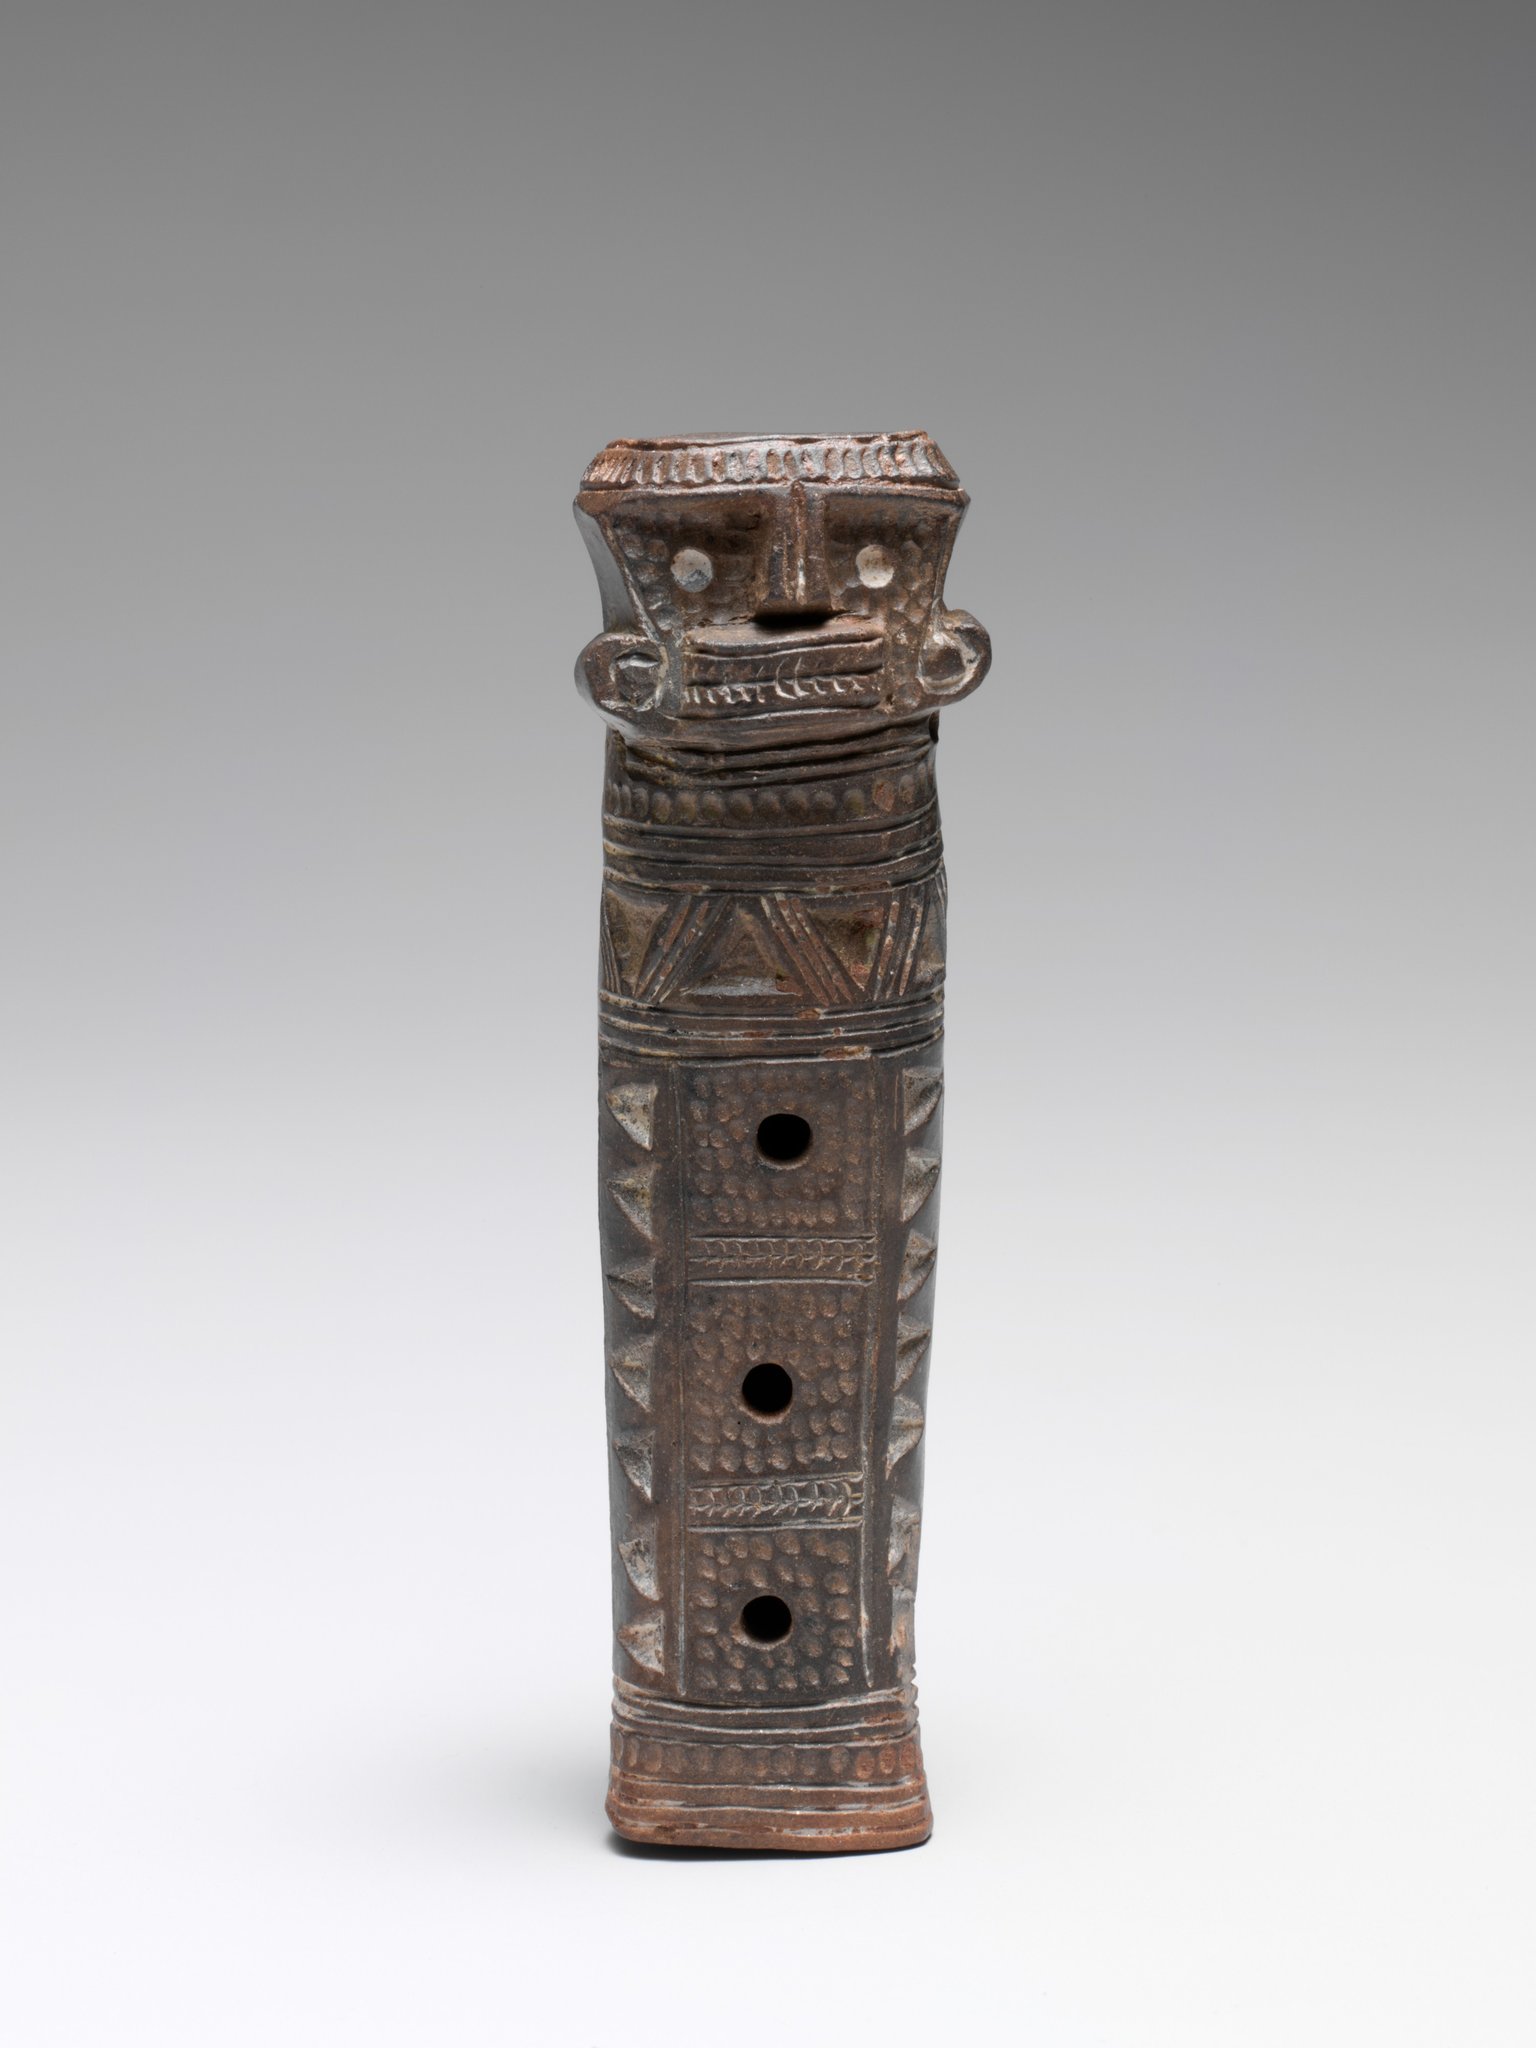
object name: flute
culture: tairona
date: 1300-1500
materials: ceramic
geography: colombia